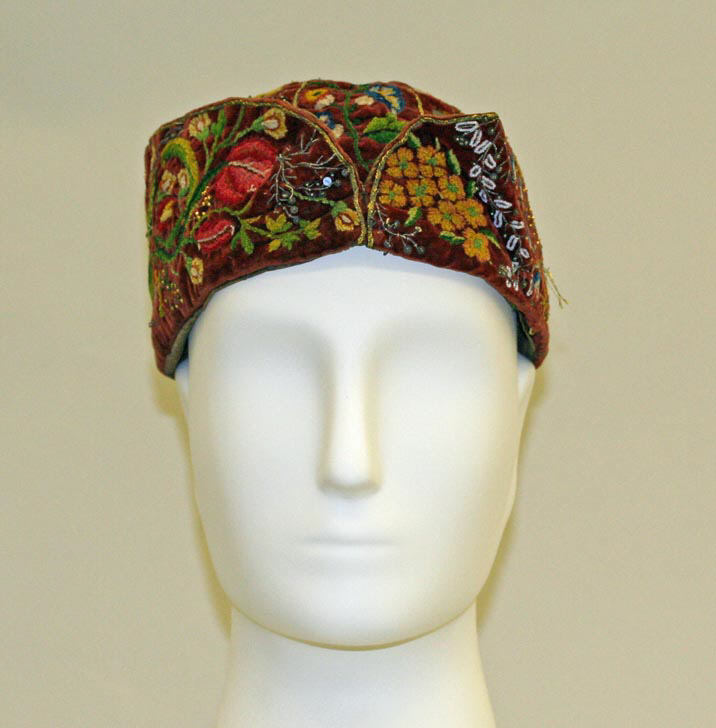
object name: cap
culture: european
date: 1820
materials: leather, silk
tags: flowers